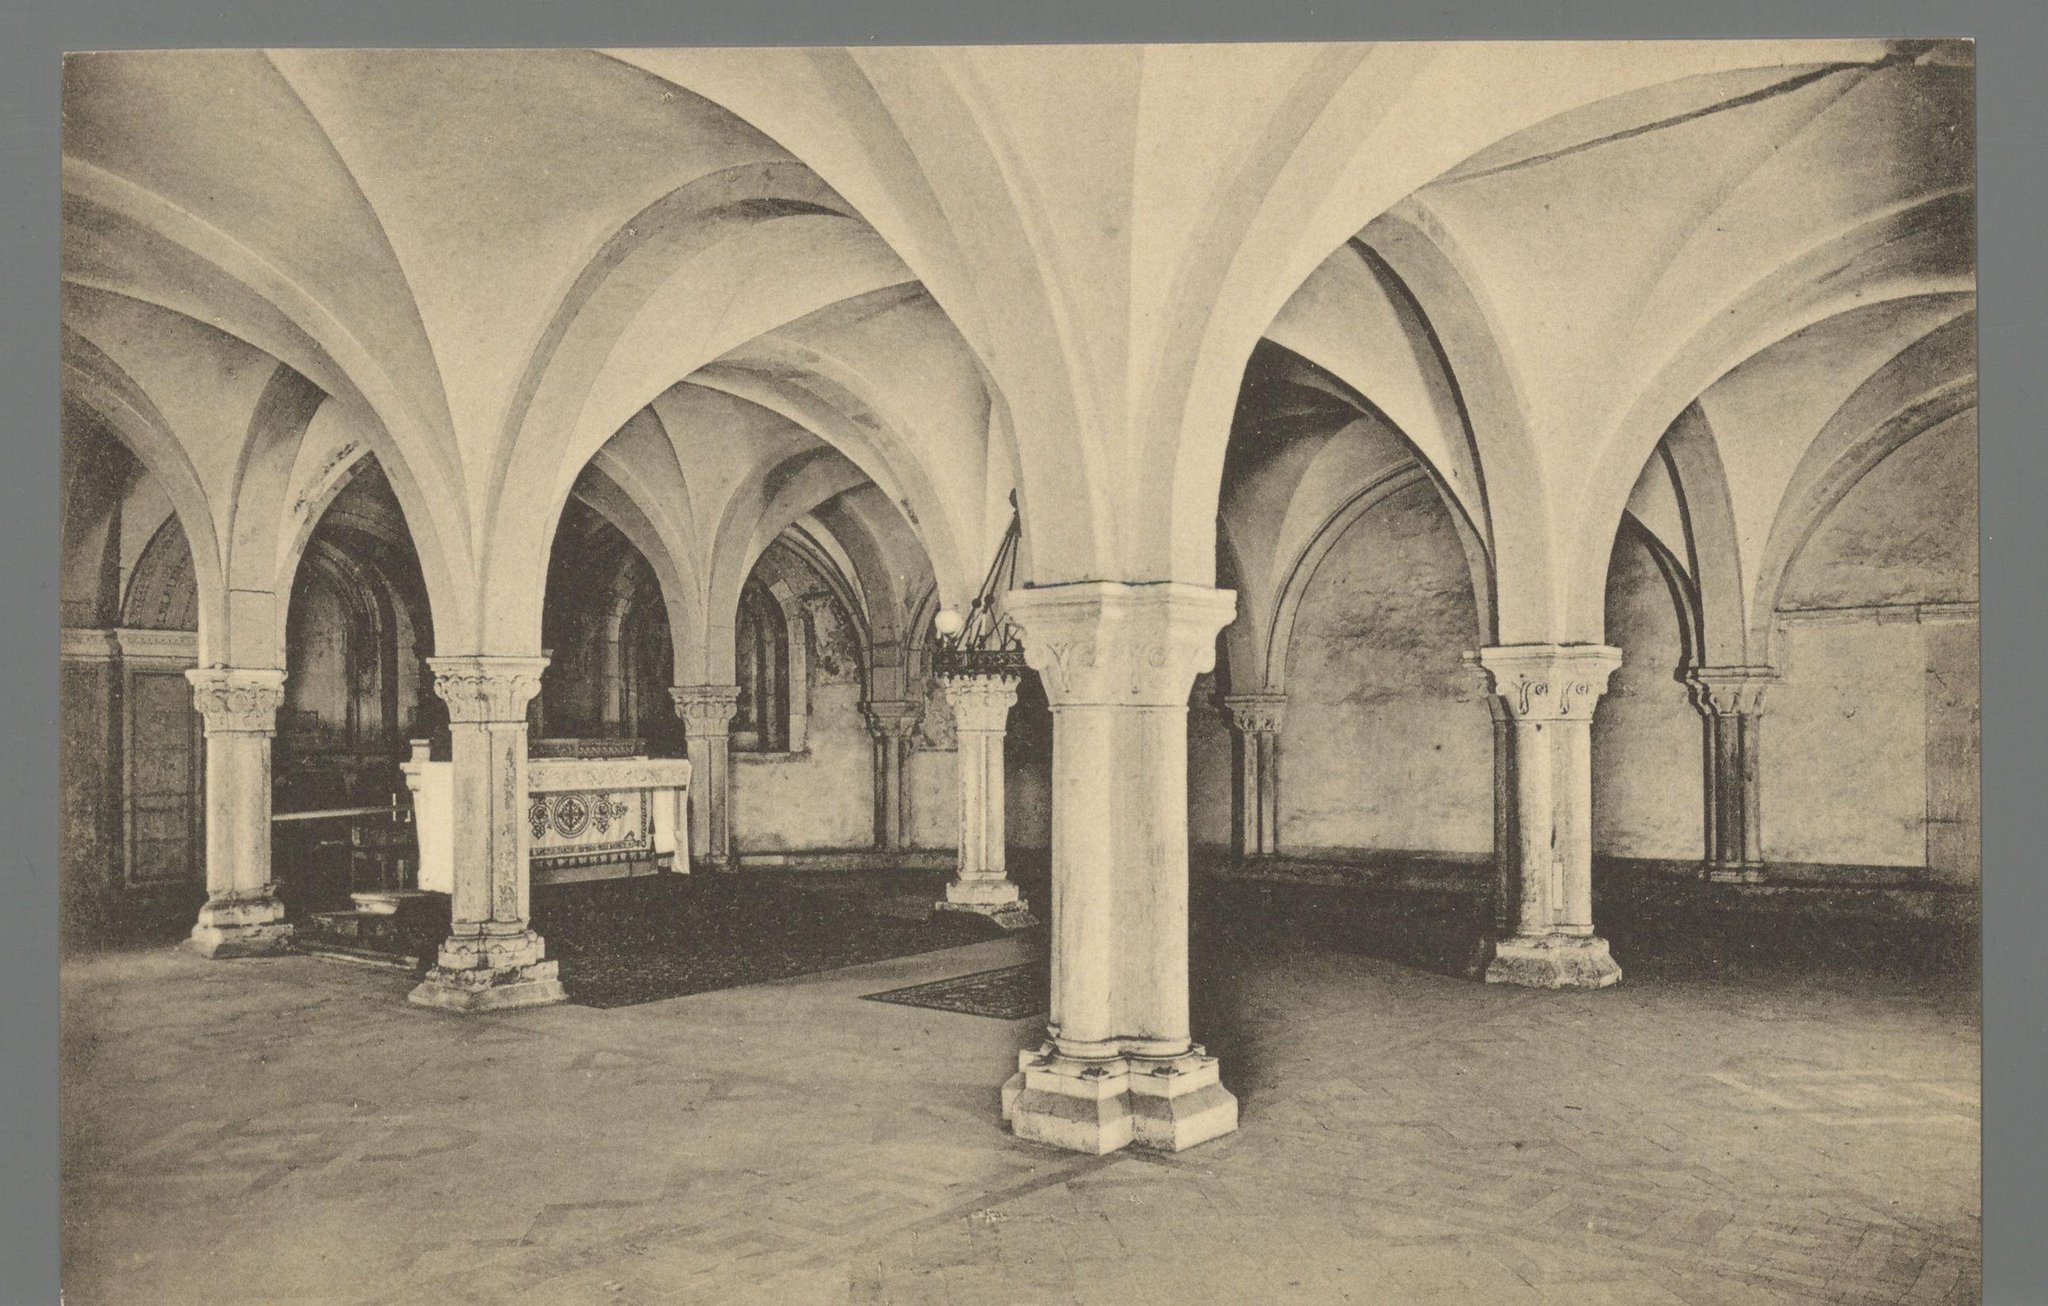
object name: ansichtkaart, prentbriefkaart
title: Dom zu Trier. Ostkrypta (12. Jahrh.)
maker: Anonymous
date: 1905-1930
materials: cardboard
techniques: photograph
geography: trier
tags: interior of church, parts of church interior (crypt)